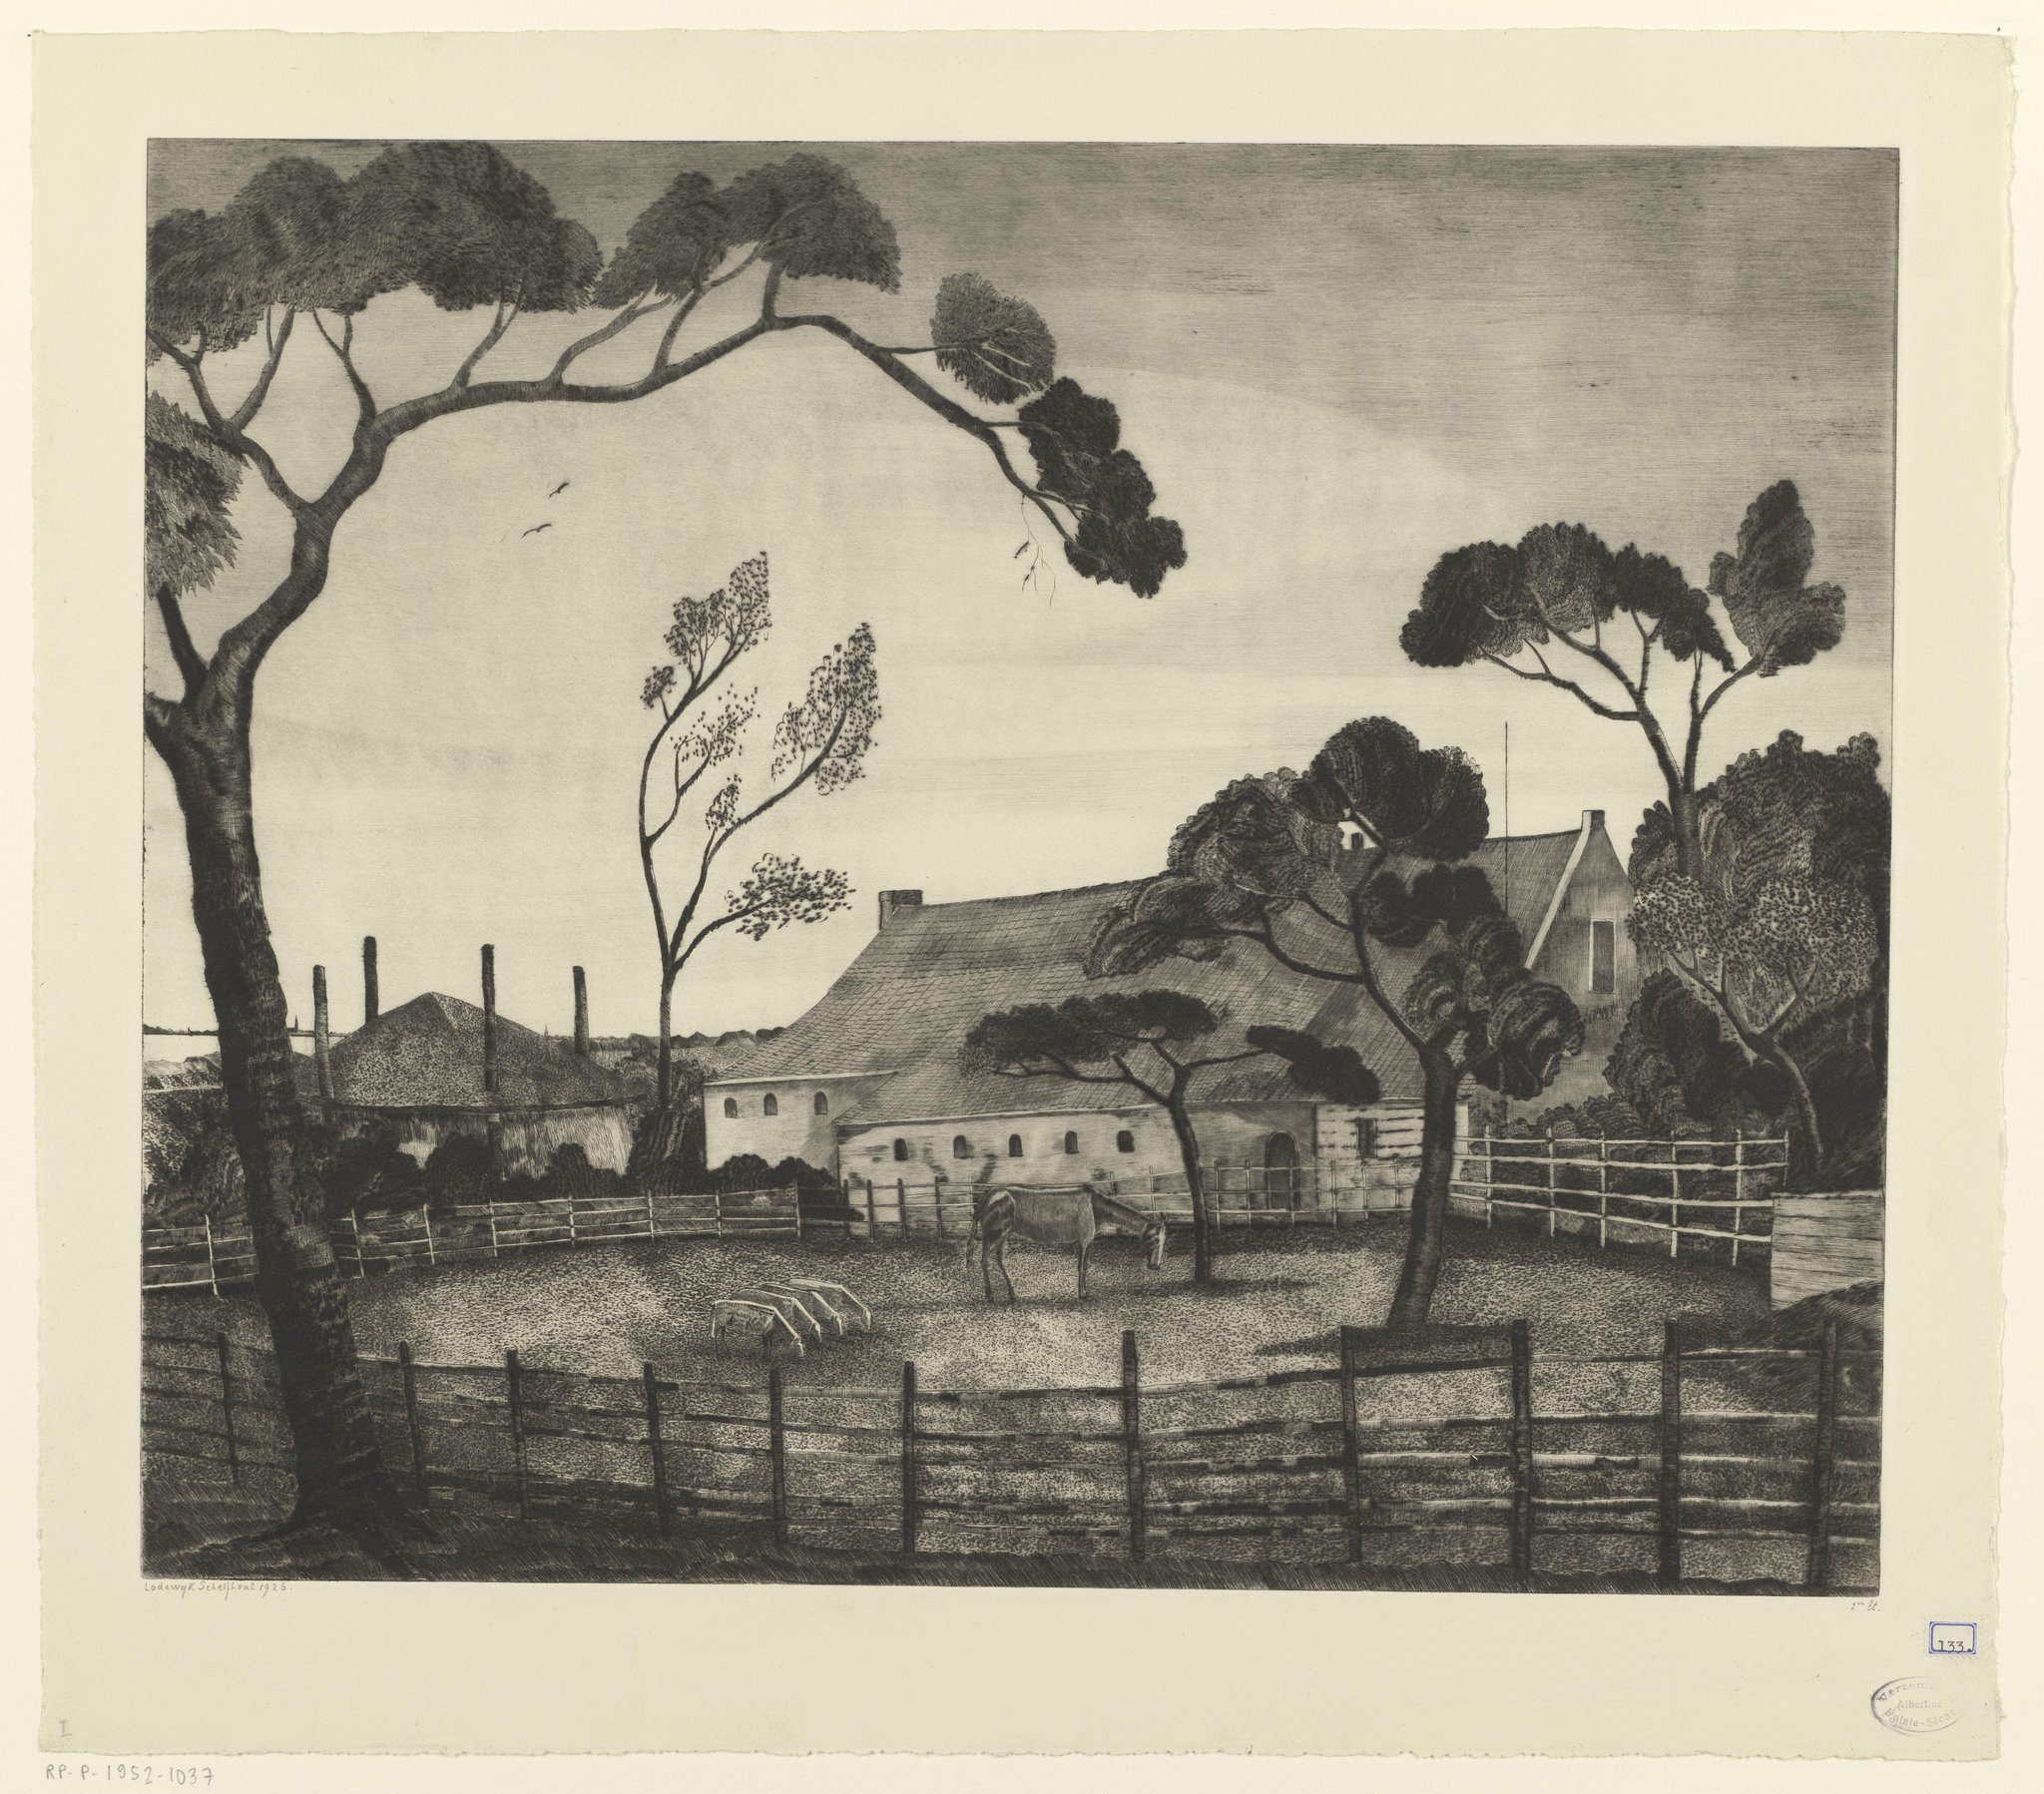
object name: print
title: Hollands landschap met boerderij en weiland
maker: lodewijk schelfhout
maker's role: draughtsman, print maker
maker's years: 1881-1943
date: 1926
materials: paper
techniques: drypoint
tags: cattle, fence, wall, paling, farm or solitary house in landscape, holland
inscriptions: collector's mark: Lugt 2228, collector's mark: Lugt 5i, collector's mark: Lugt 2760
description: Een boerderij met hooischuur. Op de voorgrond bomen en een weiland dat wordt begrensd door een hek. Er bevinden zich vier schapen en een ezel op het weiland.